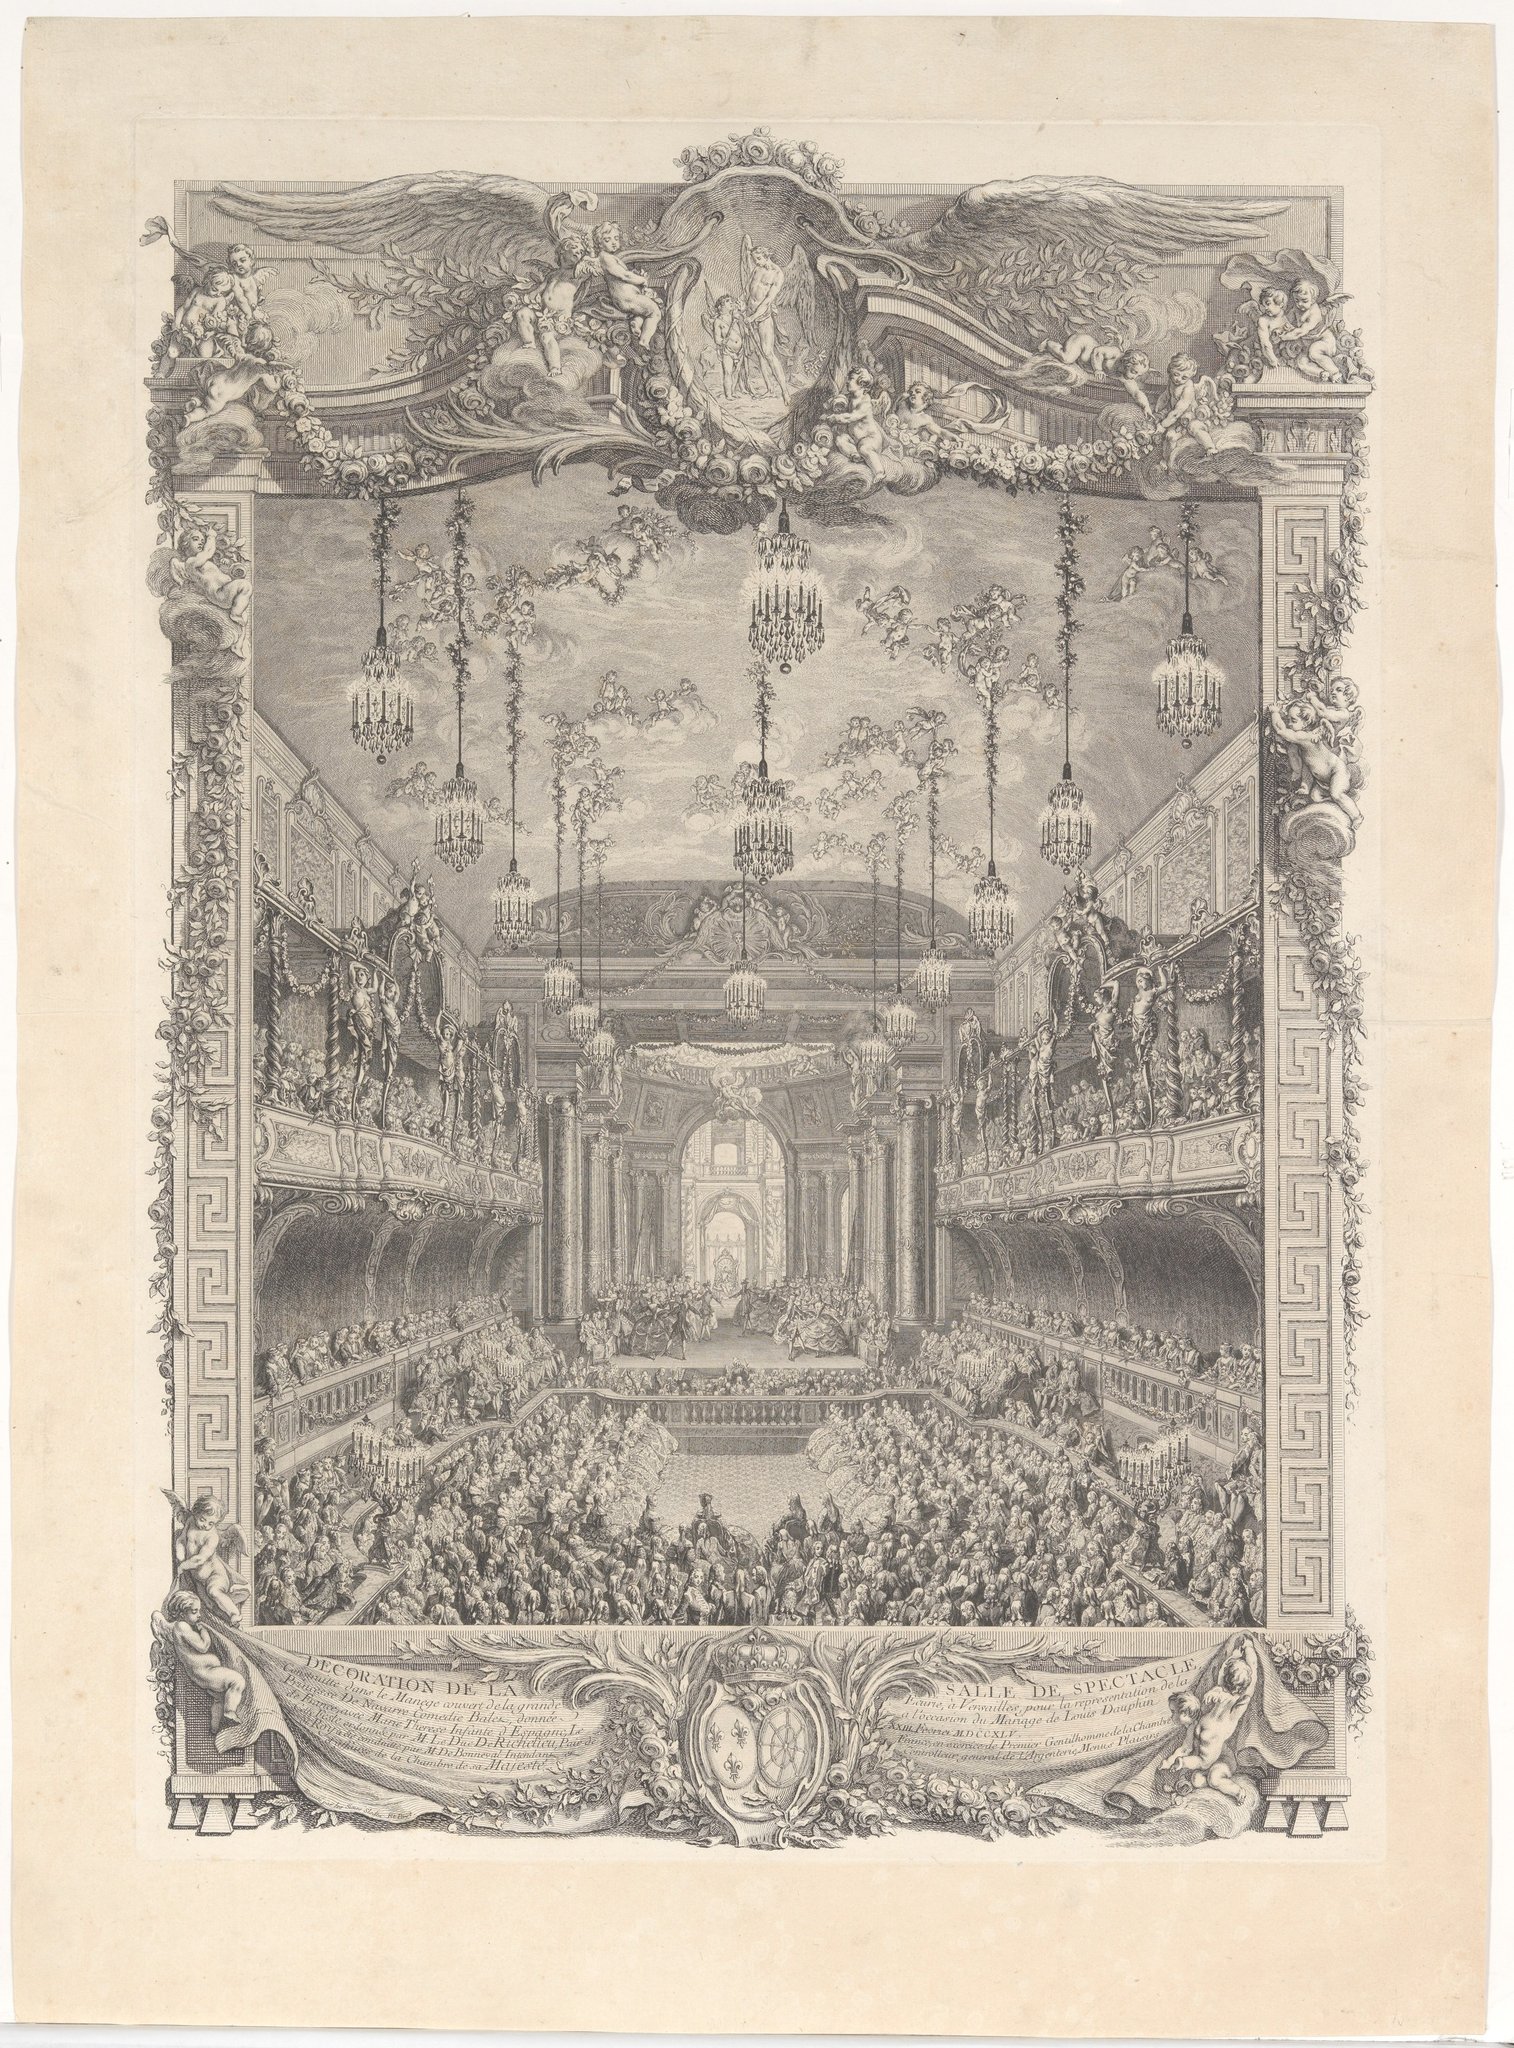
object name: print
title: Decoration de la salle de spectacle construite a Versailles pour la representation de la Princesse de Navarre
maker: charles nicolas cochin ii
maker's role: artist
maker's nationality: french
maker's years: 1715-1790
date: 1745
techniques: etching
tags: performance,theatre,interiors,crowd,coat of arms